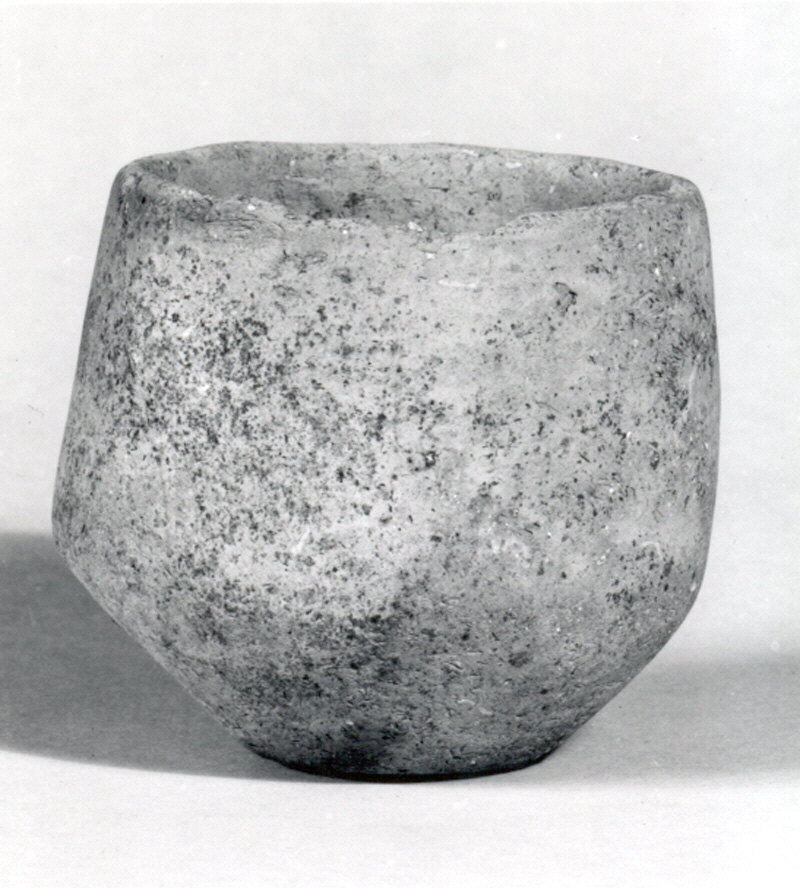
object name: cup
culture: iranian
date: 6000-5668 BCE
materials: ceramic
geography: iran